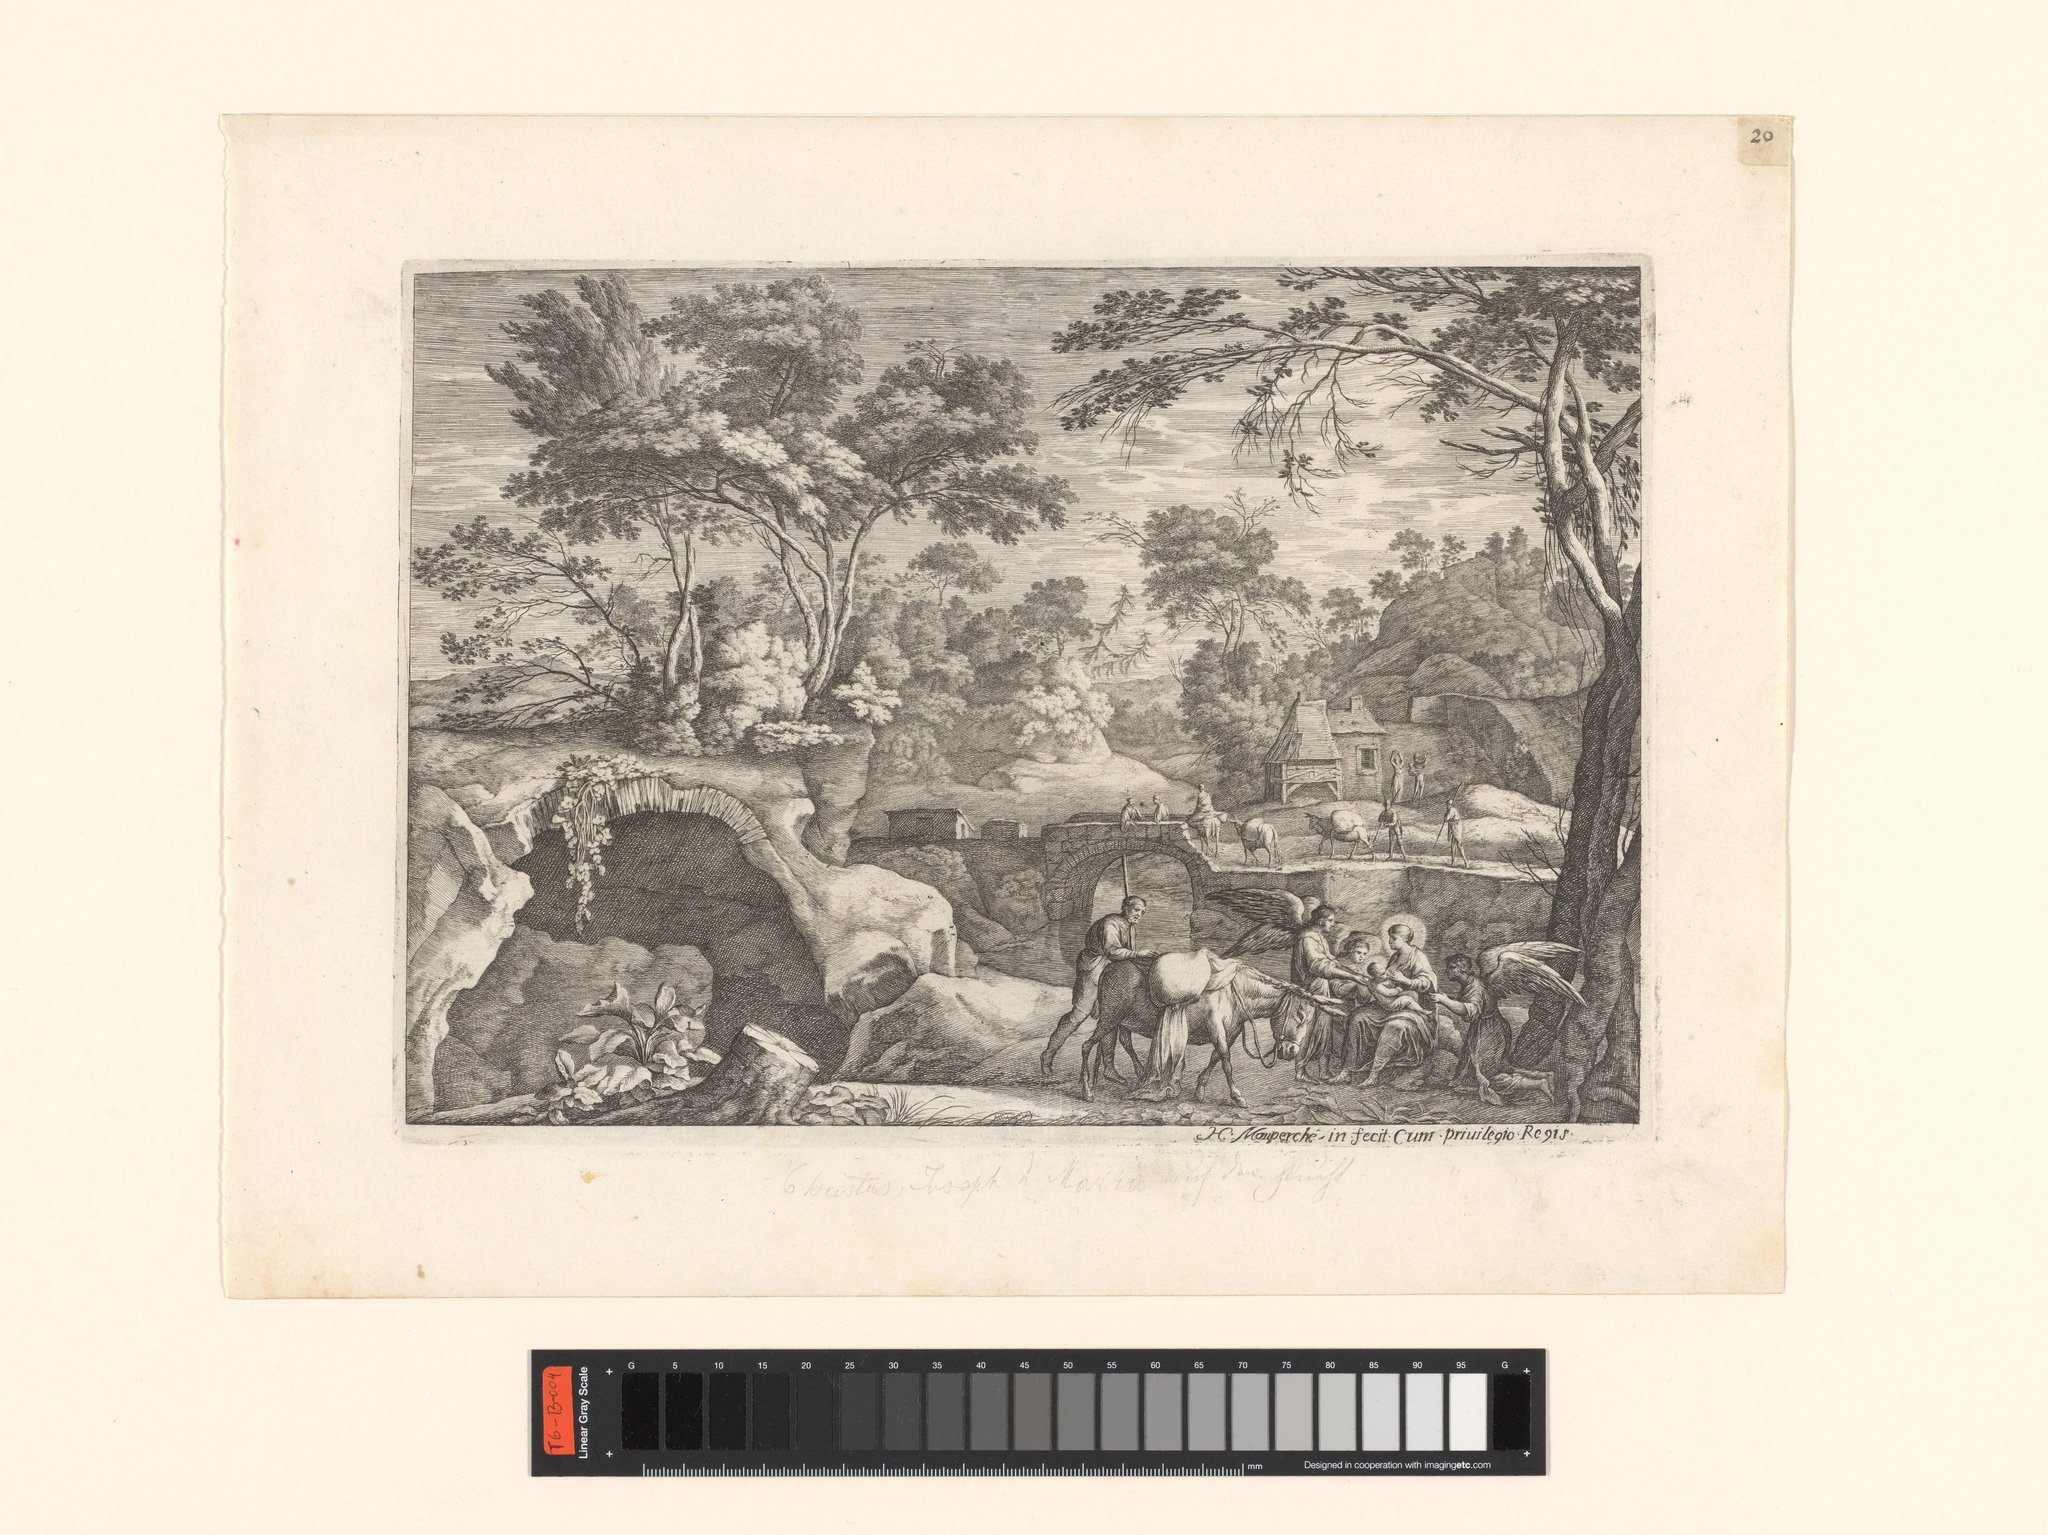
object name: print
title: Rust op de vlucht naar Egypte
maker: henri mauperché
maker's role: painter, print maker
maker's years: 1602-1686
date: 1639-1656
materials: paper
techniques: etching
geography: paris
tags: rest on the flight into egypt, rest on the flight into egypt - bb - landscape predominant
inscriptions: collector's mark: Lugt 2228, collector's mark: Lugt 2760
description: Het gaat om afdrukken van de eerste staat vóór het adres van Giffart. Ze zijn afkomstig uit een prentalbum, zoals blijkt uit ruime marges en folio-nummering in bruine inkt. RP-P-2019-196 t/m 201.